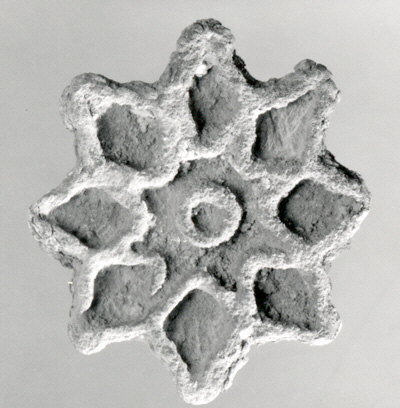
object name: stamp seal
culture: bactria-margiana archaeological complex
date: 2333-1668 BCE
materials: copper alloy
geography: bactria-margiana